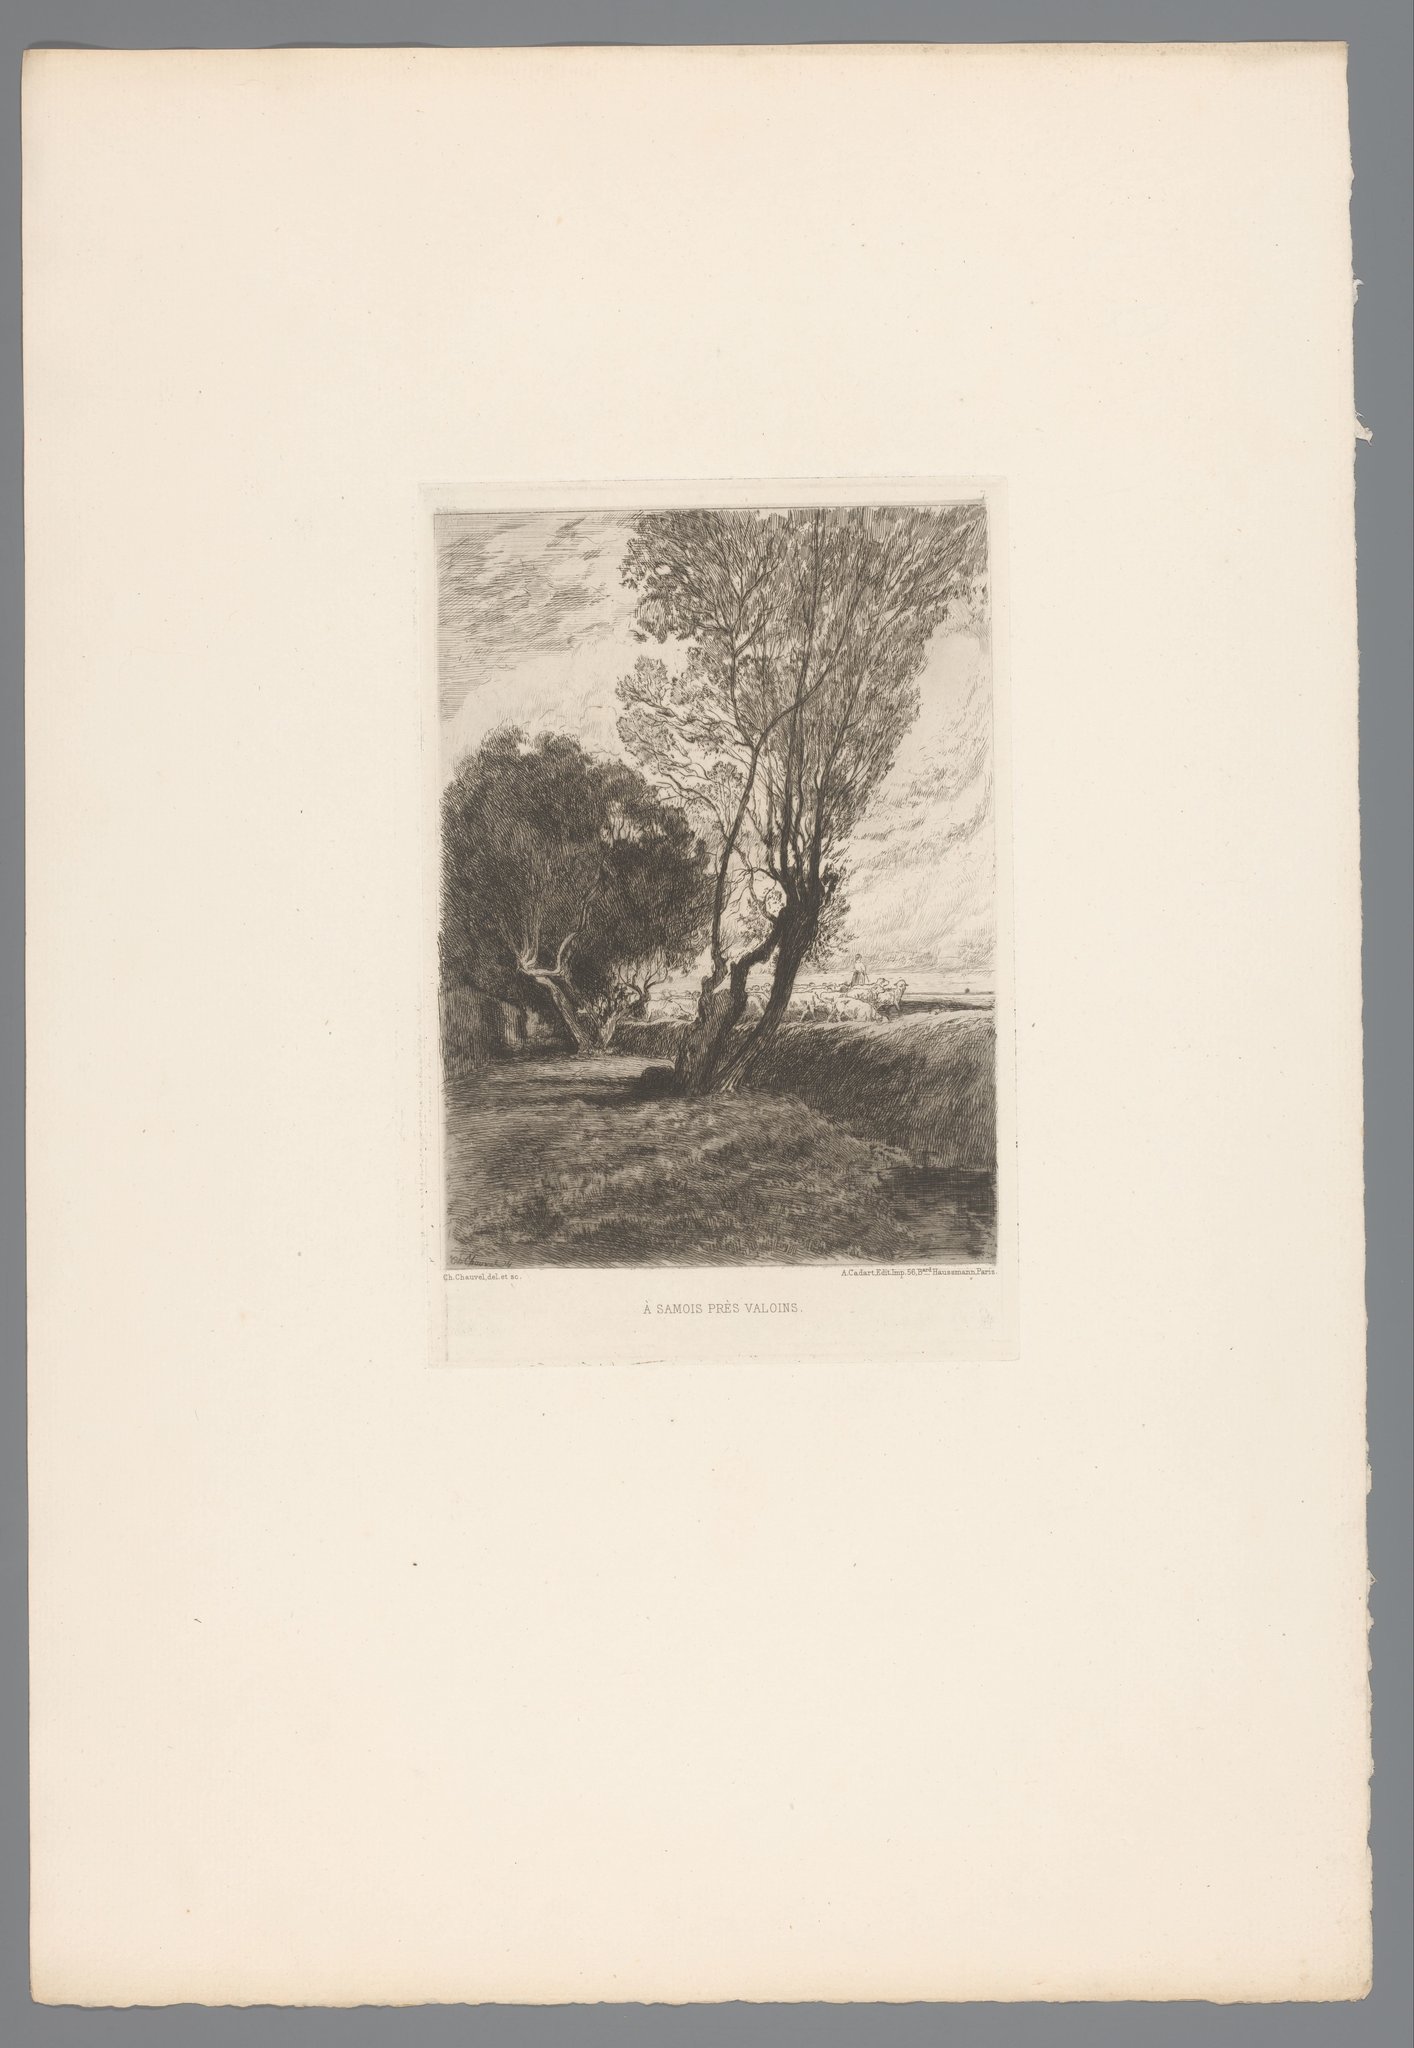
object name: print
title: L'eau-forte en 1875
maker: alfred cadart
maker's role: print maker, printer, publisher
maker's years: 1828-1875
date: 1875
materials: paper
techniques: drypoint, etching, intaglio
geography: paris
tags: landscapes, herd, flock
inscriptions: collector's mark: Lugt 2760, collector's mark: Lugt 2228, collector's mark: ‘AFE v S’